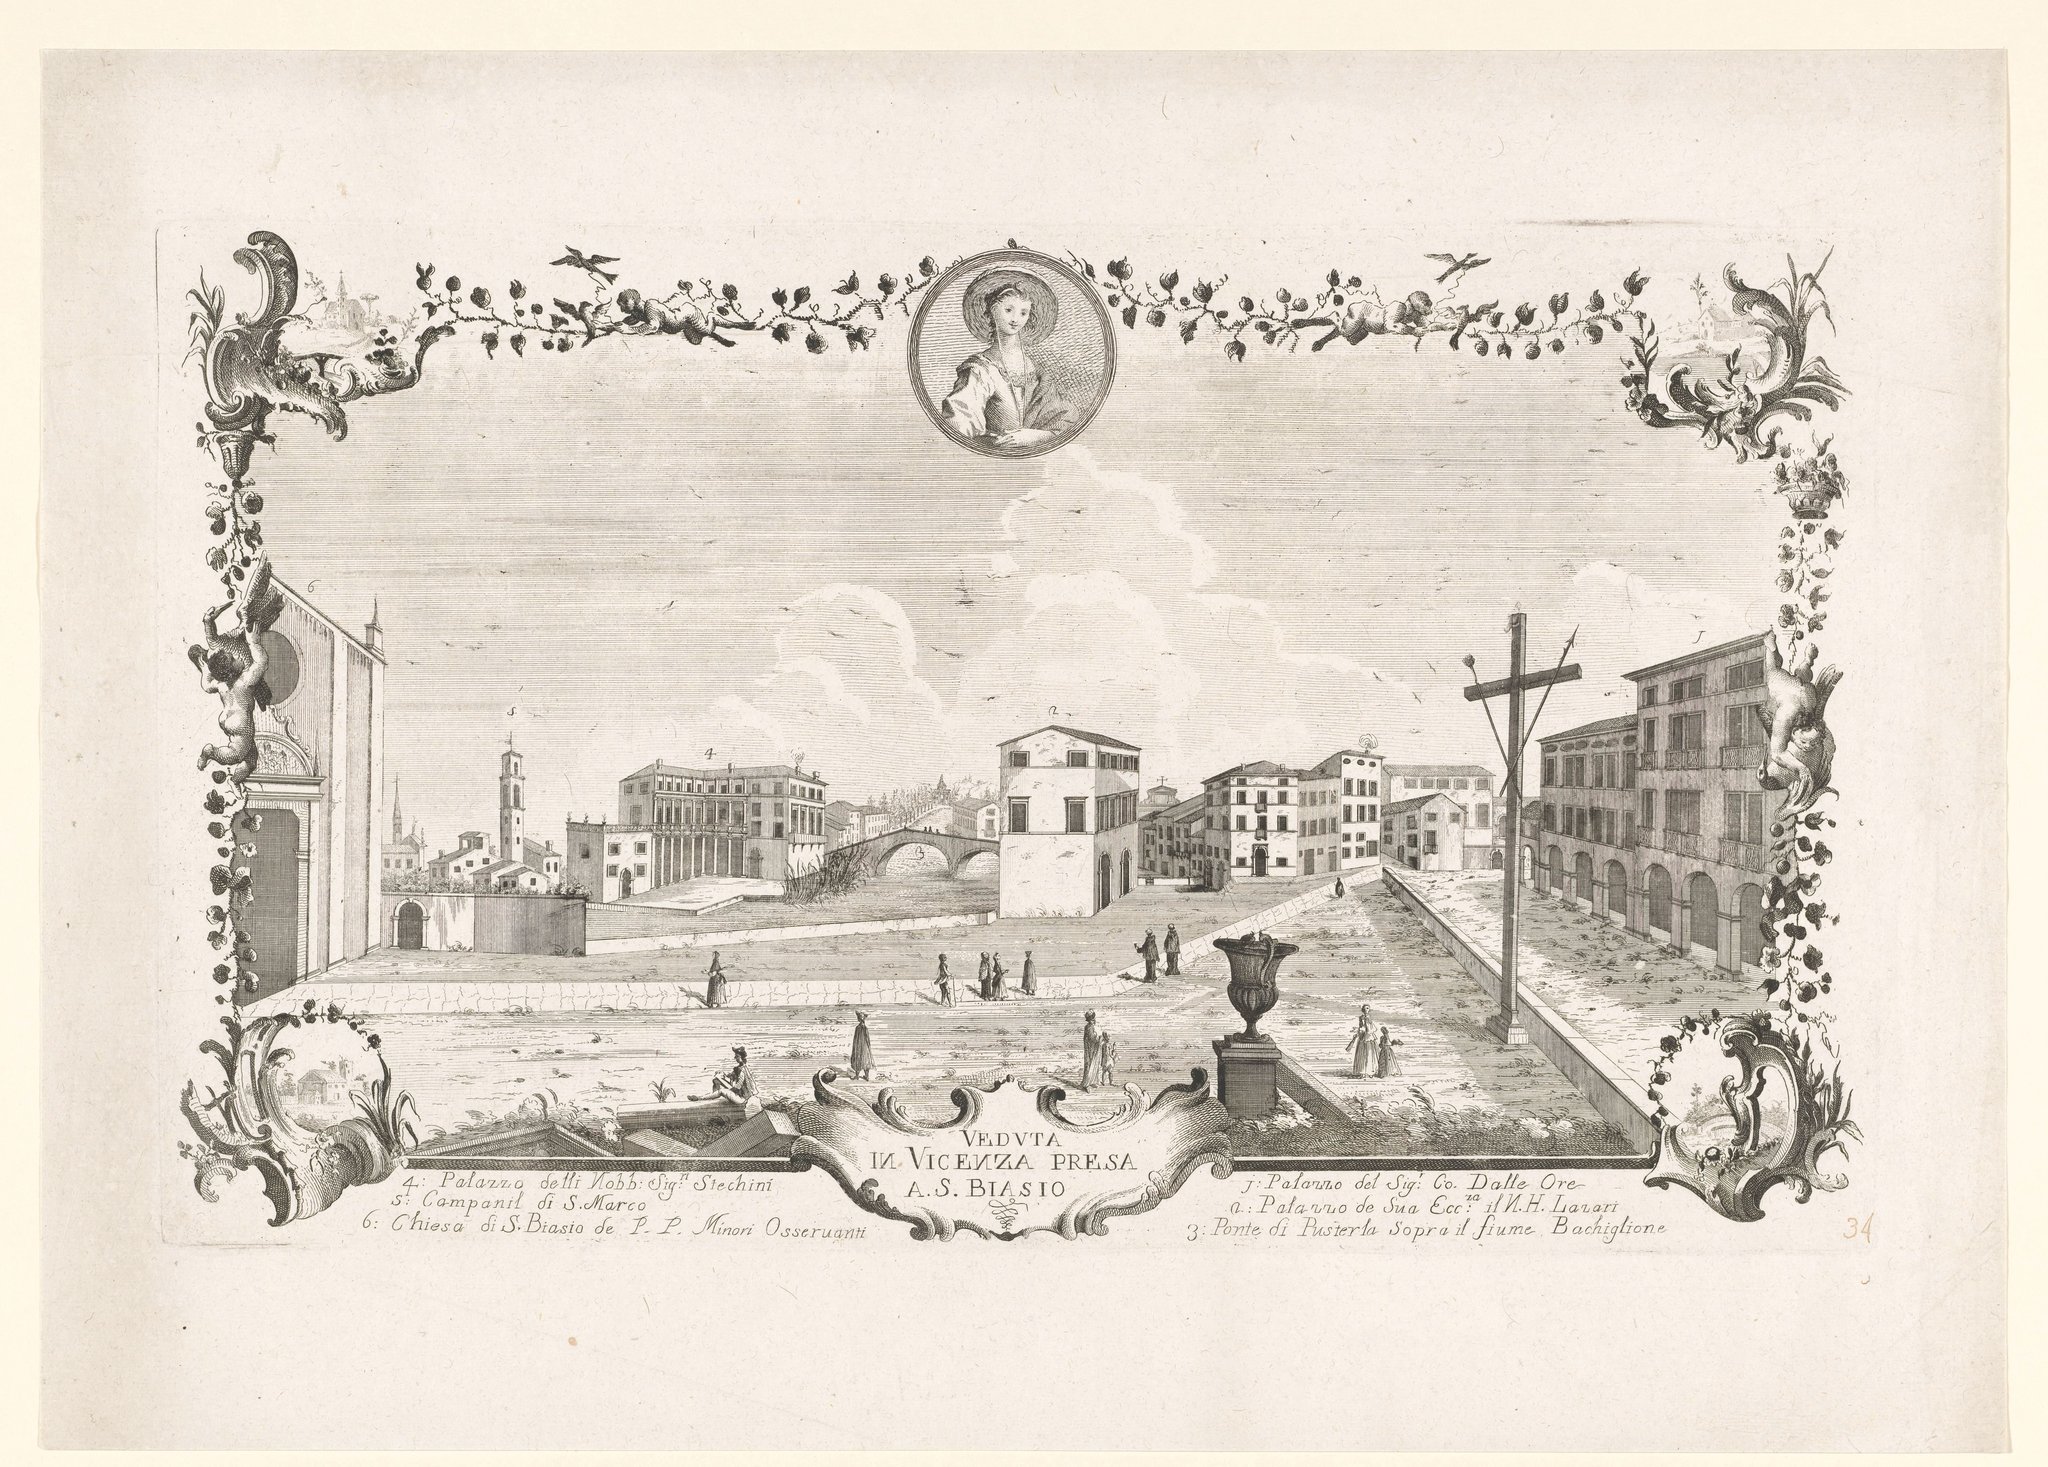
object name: print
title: Vedute vicentine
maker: cristoforo dall acqua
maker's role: draughtsman, print maker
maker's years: 1734-1787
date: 1744-1787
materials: paper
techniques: etching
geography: italy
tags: city-view, and landscape with man-made constructions, river, parts of church exterior and annexes: façade, hôtel, i.e. small palace in city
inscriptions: collector's mark: Lugt 2228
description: Gezicht op de Chiesa di S. Biasio en omliggende gebouwen, waaronder de Campanille di S. Marco en het Palazzo Gualdo Dalle Ore, in Vicenza. Rond de voorstelling een rand van putti, vogels en bloemenranken. In de vier hoeken cartouches met voorstellingen van woningen, een kerk en een brug op het platteland. Midden boven een medaillon met een vrouwenportret. Verklarende lijst met nummers en titel in cartouche in ondermarge.